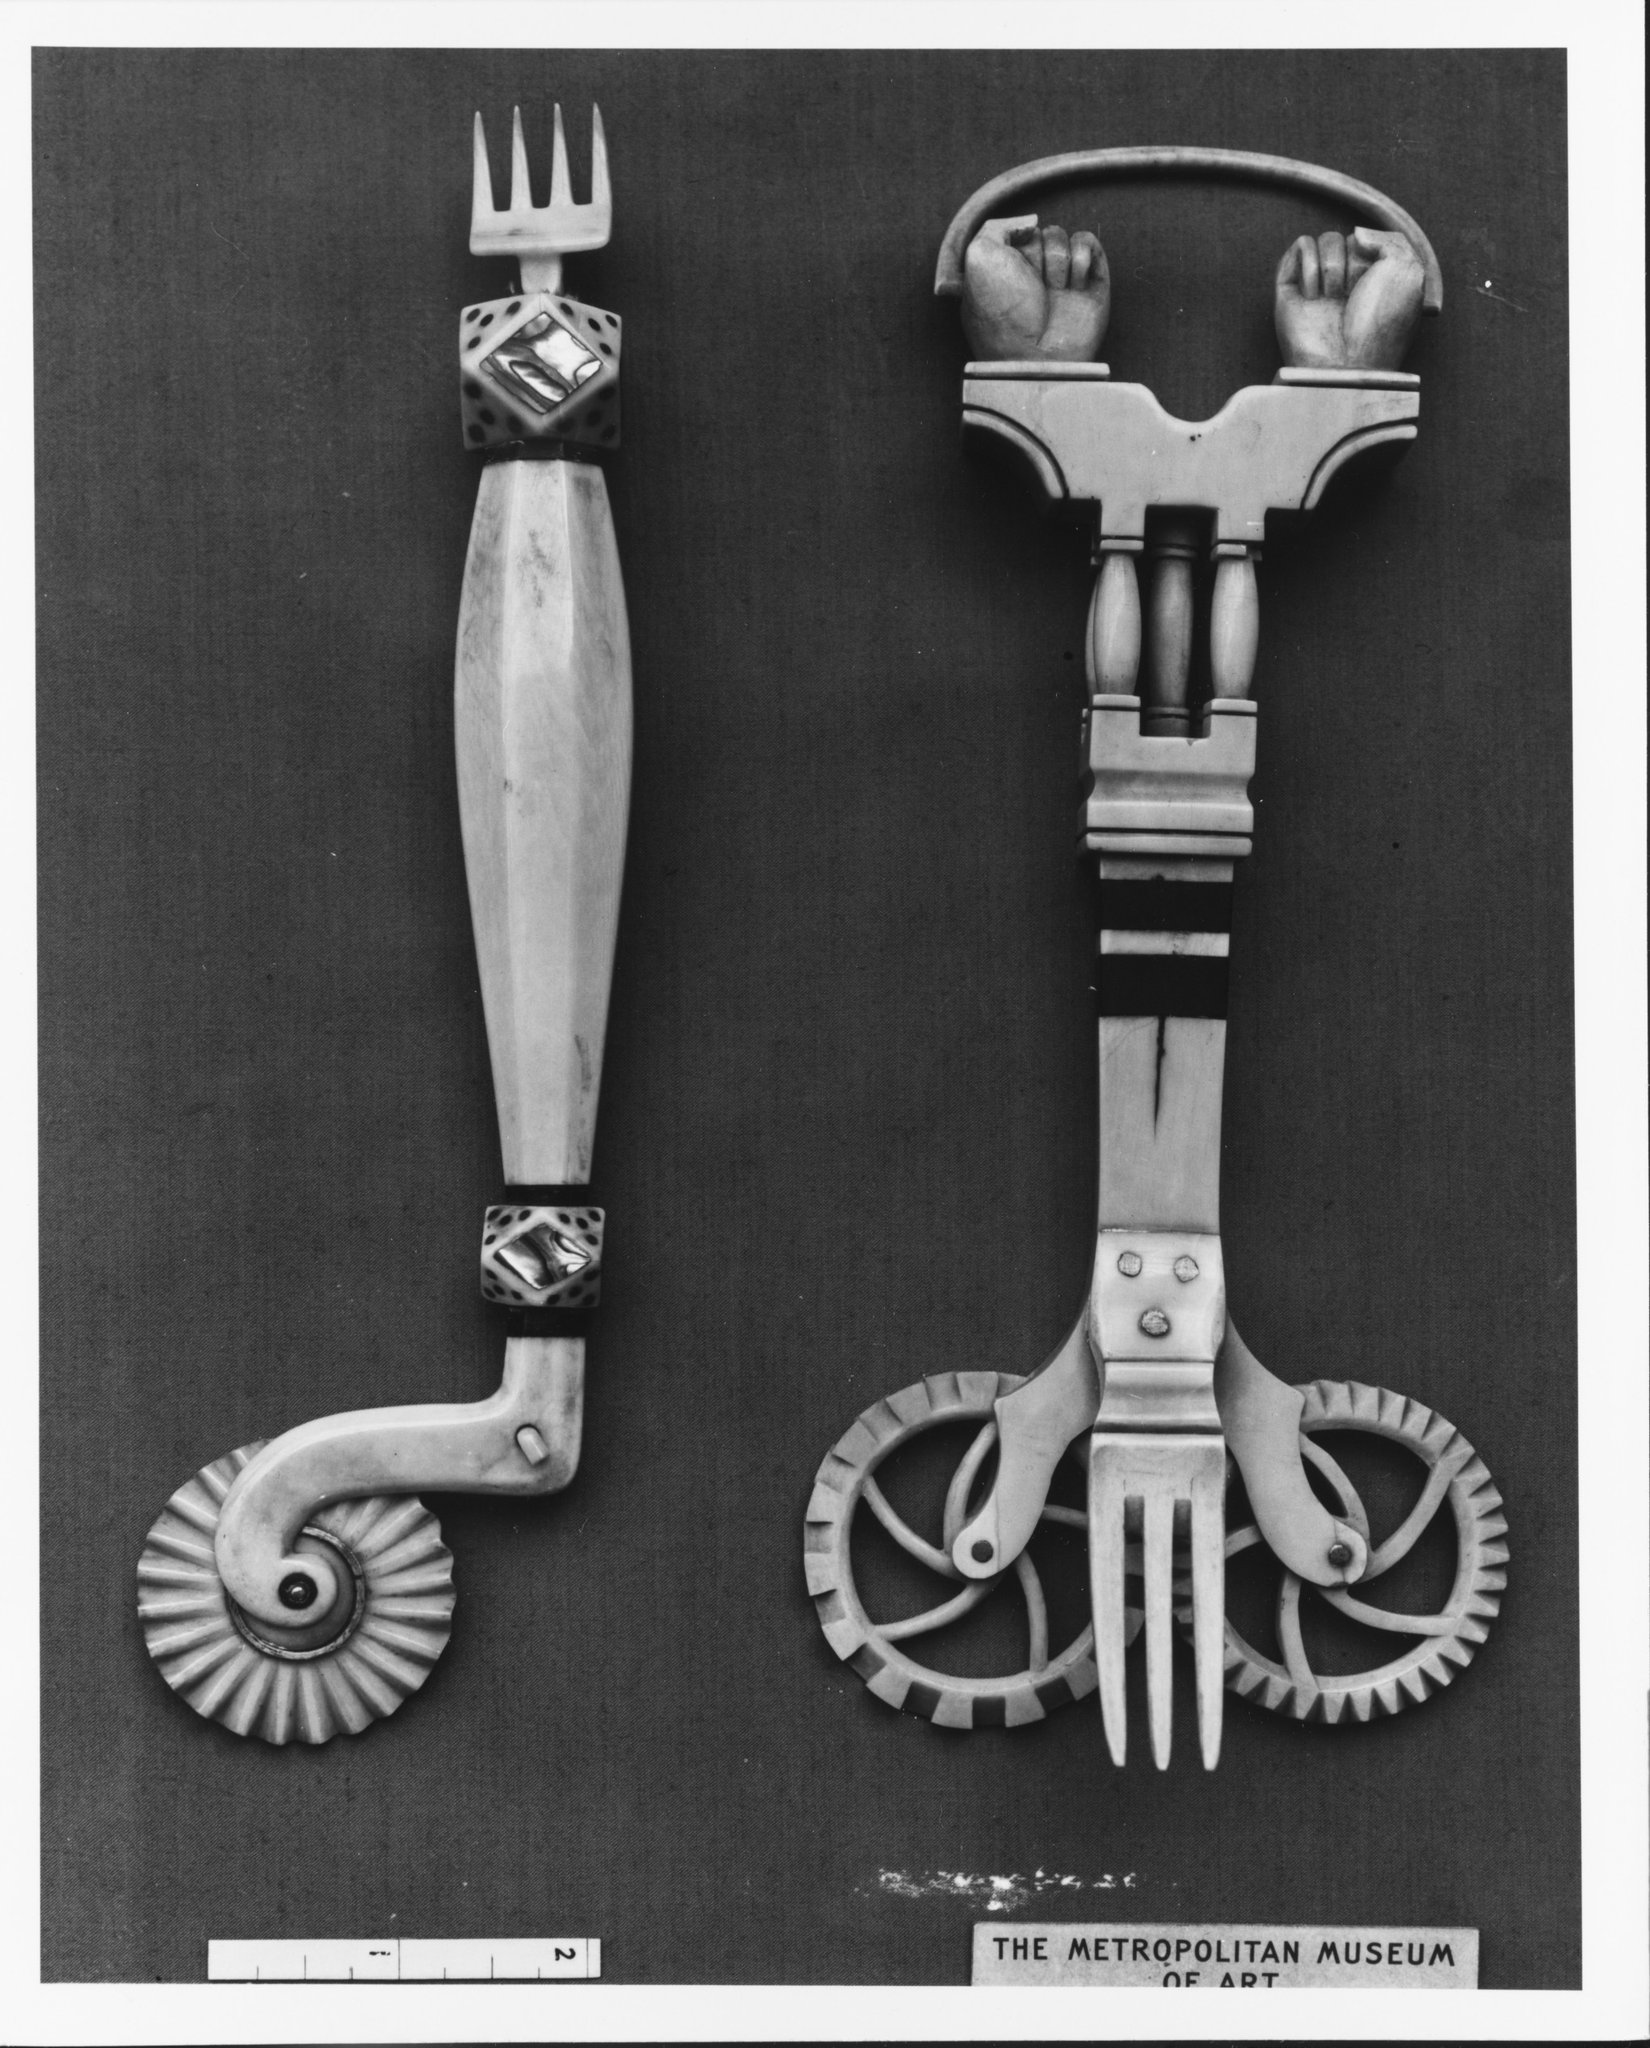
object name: jagging wheel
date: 1770-1800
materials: ivory